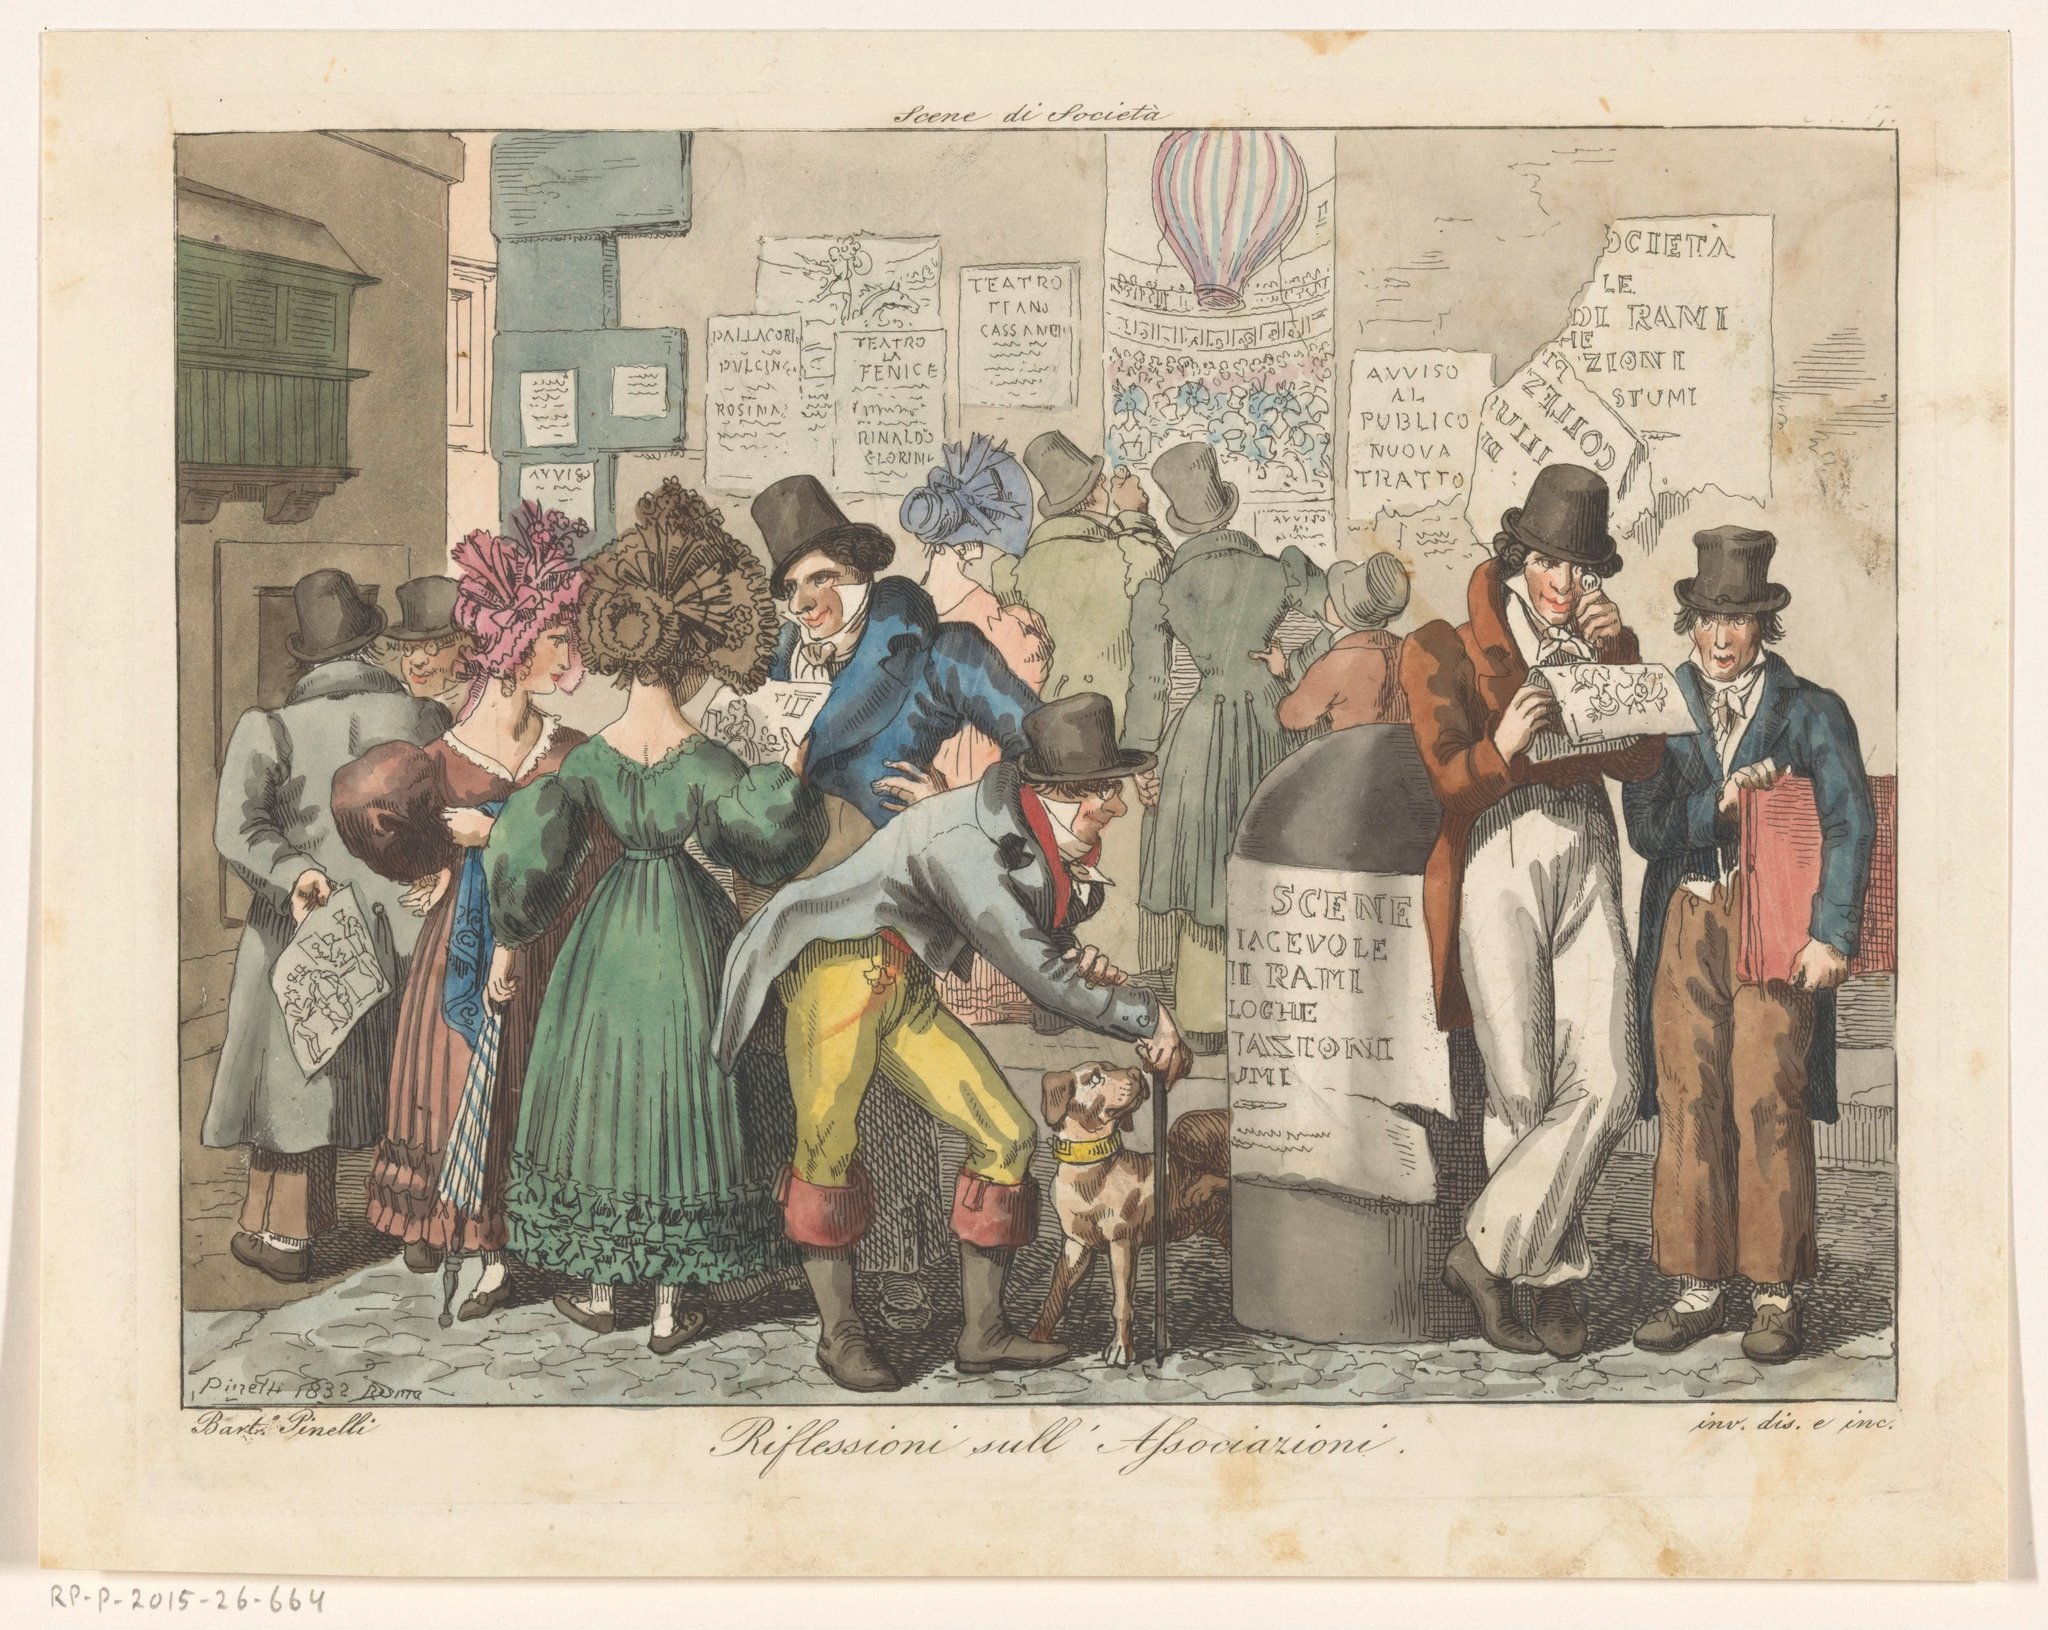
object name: print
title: Plein met mannen en vrouwen die prenten en aanplakbiljetten bekijken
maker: bartolomeo pinelli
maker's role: draughtsman, print maker, sculptor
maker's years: 1781-1835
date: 1832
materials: paper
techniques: etching, hand coloring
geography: rome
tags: print, e.g.: engraving, etching, lithograph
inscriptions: collector's mark: Lugt 2228, collector's mark: Lugt 4780